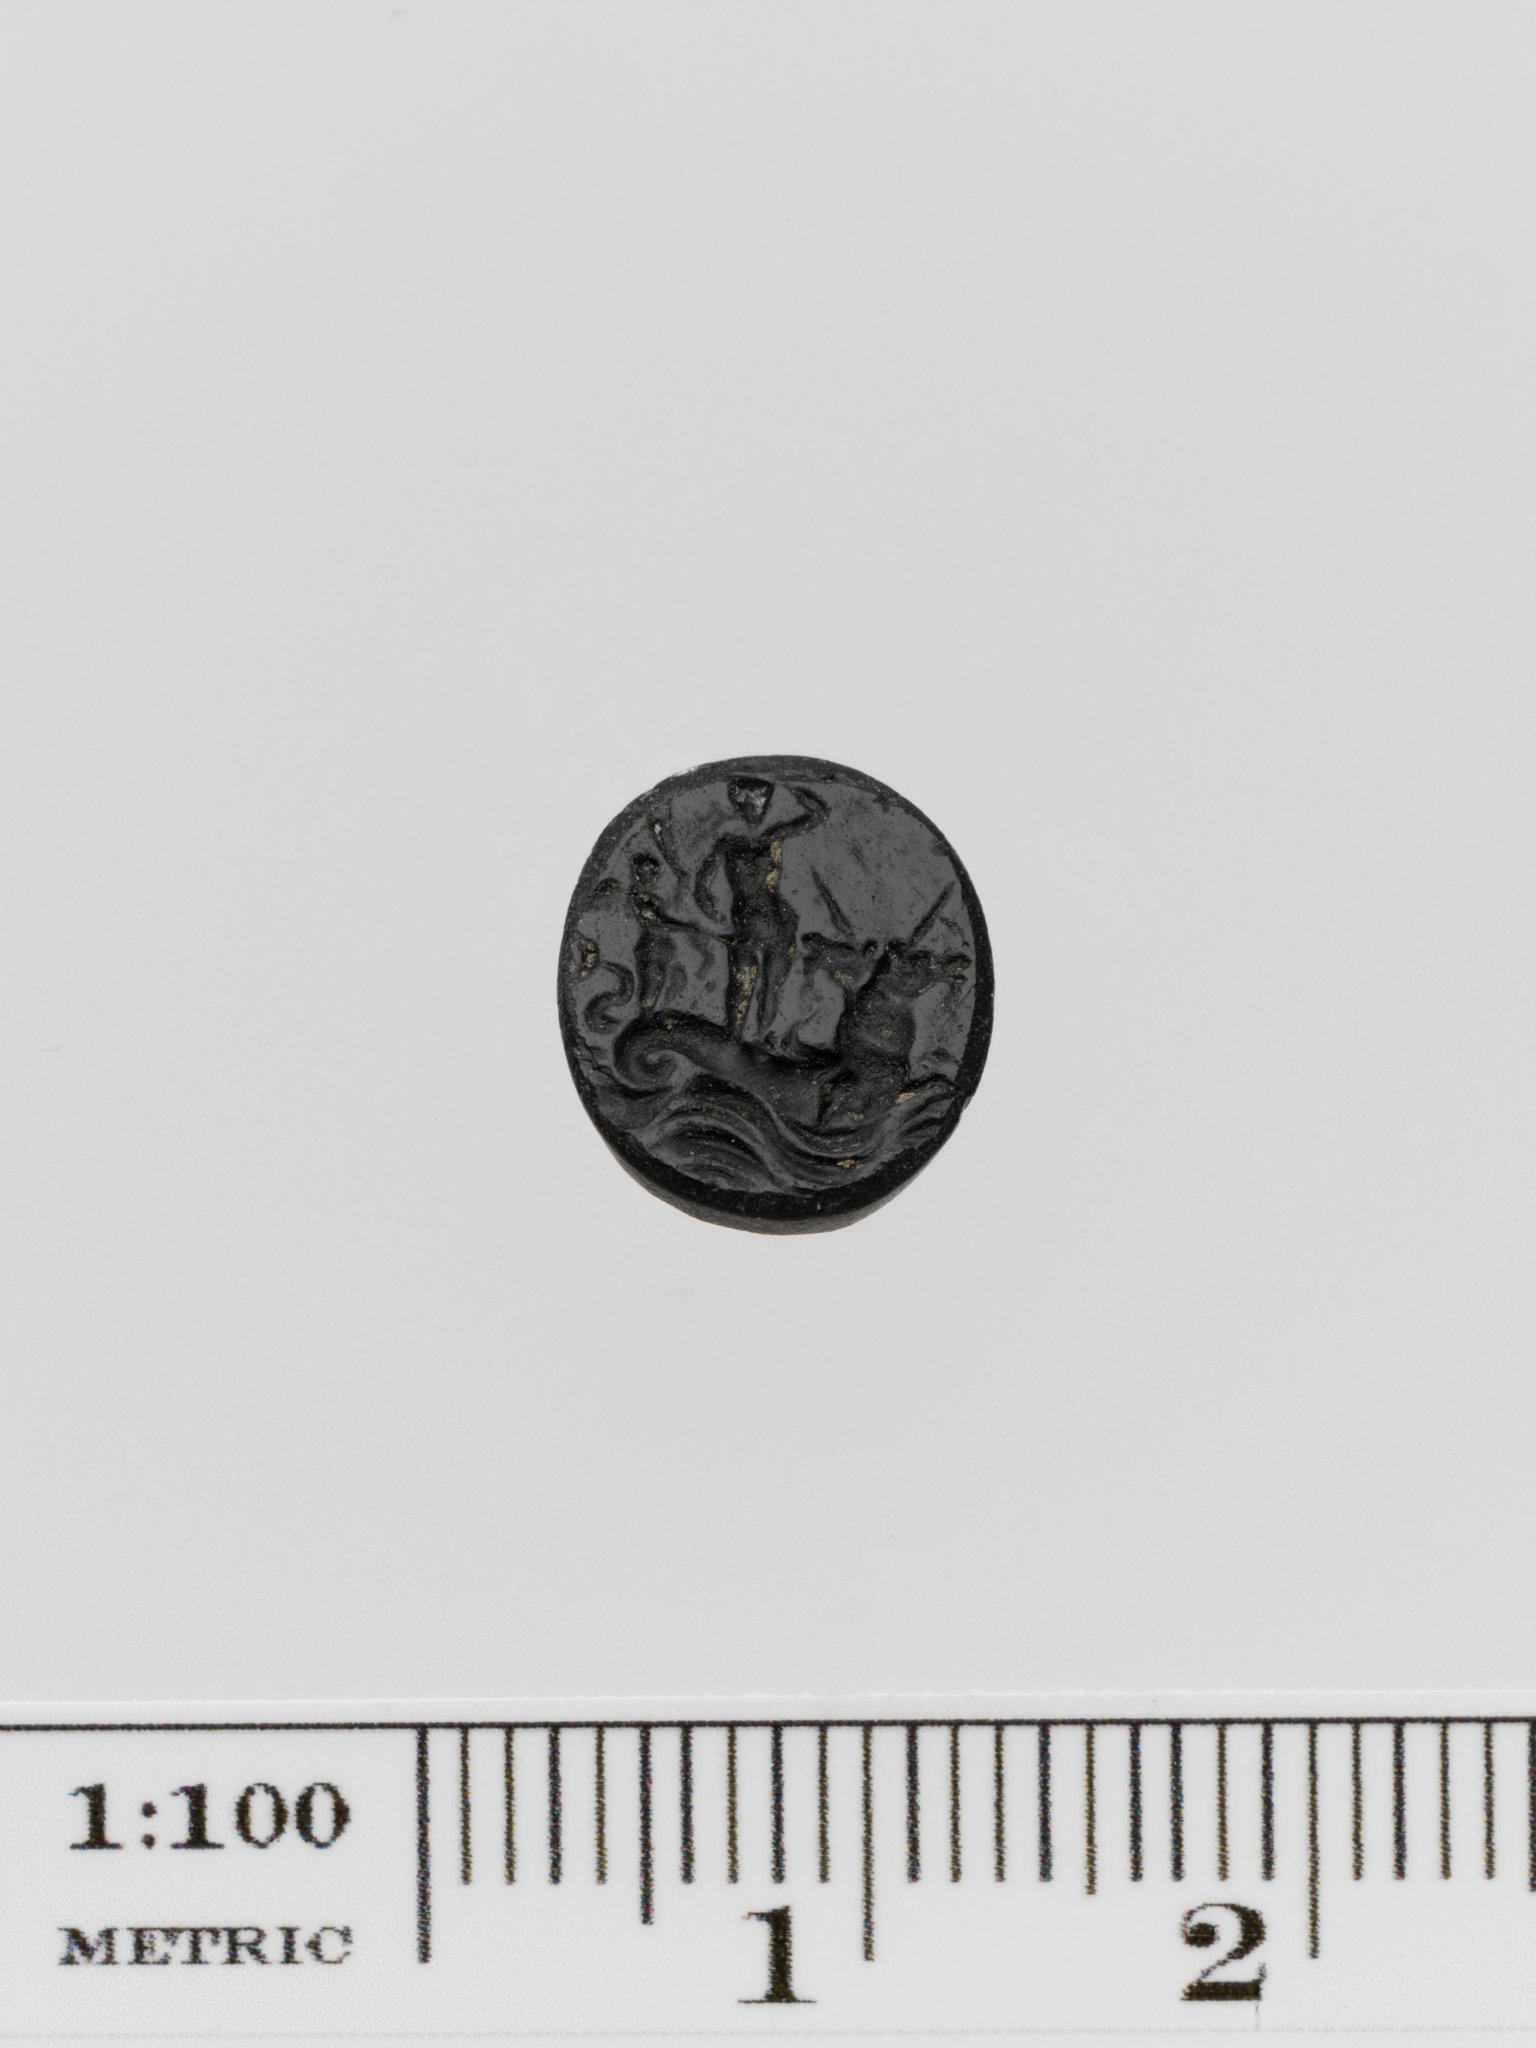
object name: intaglio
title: Black glass ring stone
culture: roman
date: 1-100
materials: glass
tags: aphrodite,eros